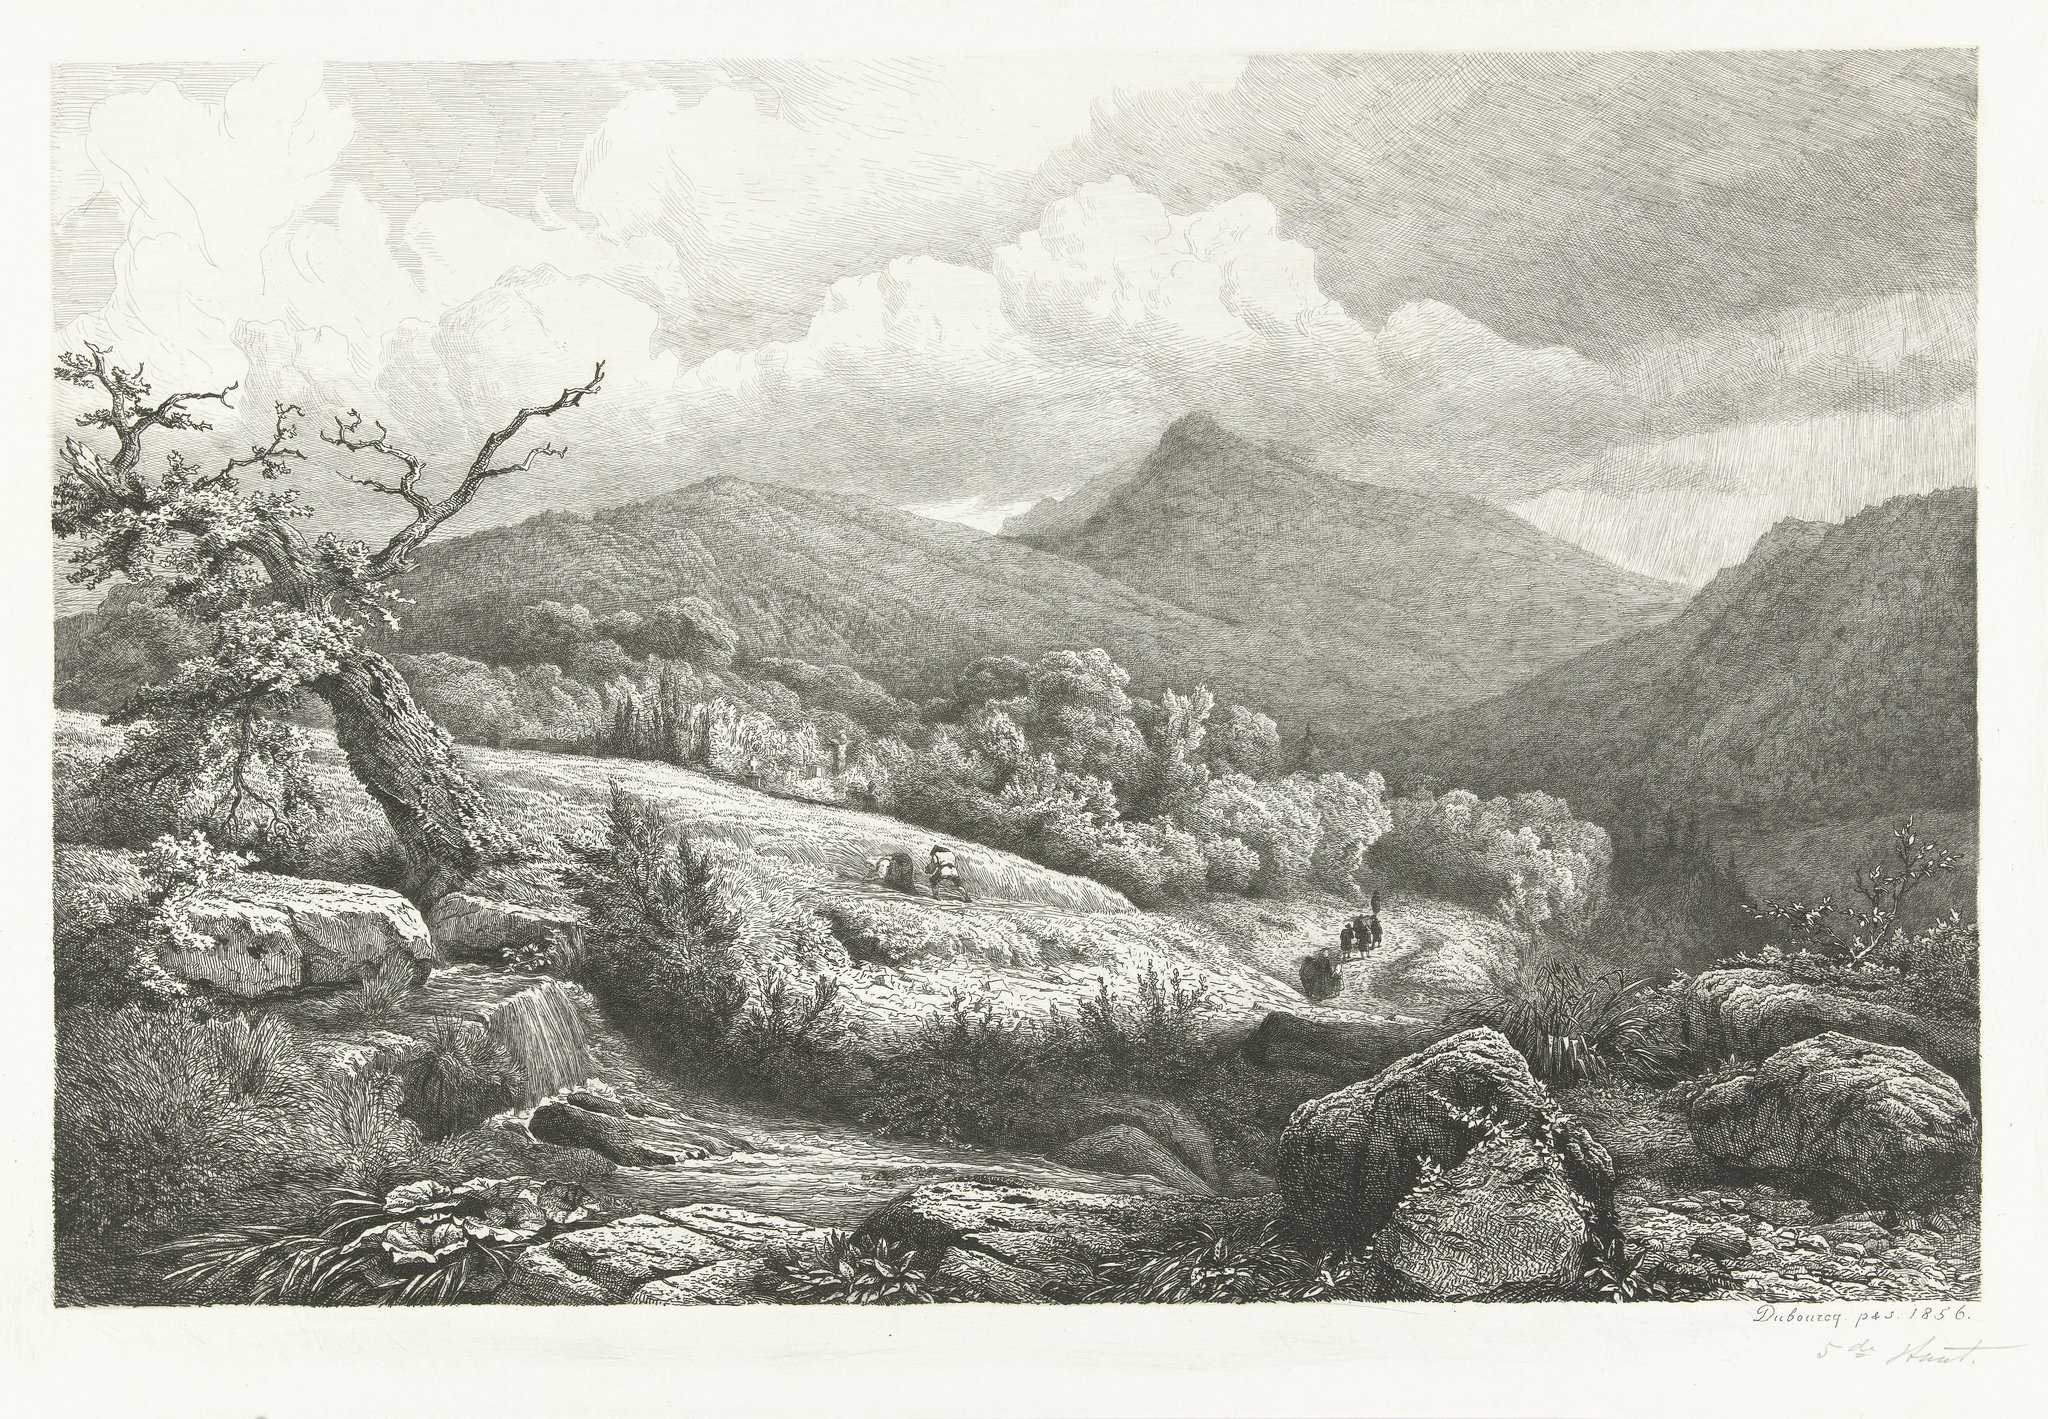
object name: print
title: De begraafplaats te Baden-Baden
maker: pierre louis dubourcq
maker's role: draughtsman, painter, print maker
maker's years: 1815-1873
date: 1856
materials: paper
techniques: etching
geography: netherlands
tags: landscape with other man-made constructions not mentioned above, e.g.: graveyards, playgrounds, etc.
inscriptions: collector's mark: Lugt 2228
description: De begraafplaats te Baden-Baden. Berglandschap met een kleine begrafenisstoet op weg naar de begraafplaats links tussen de bomen. Op de voorgrond een watervalletje.